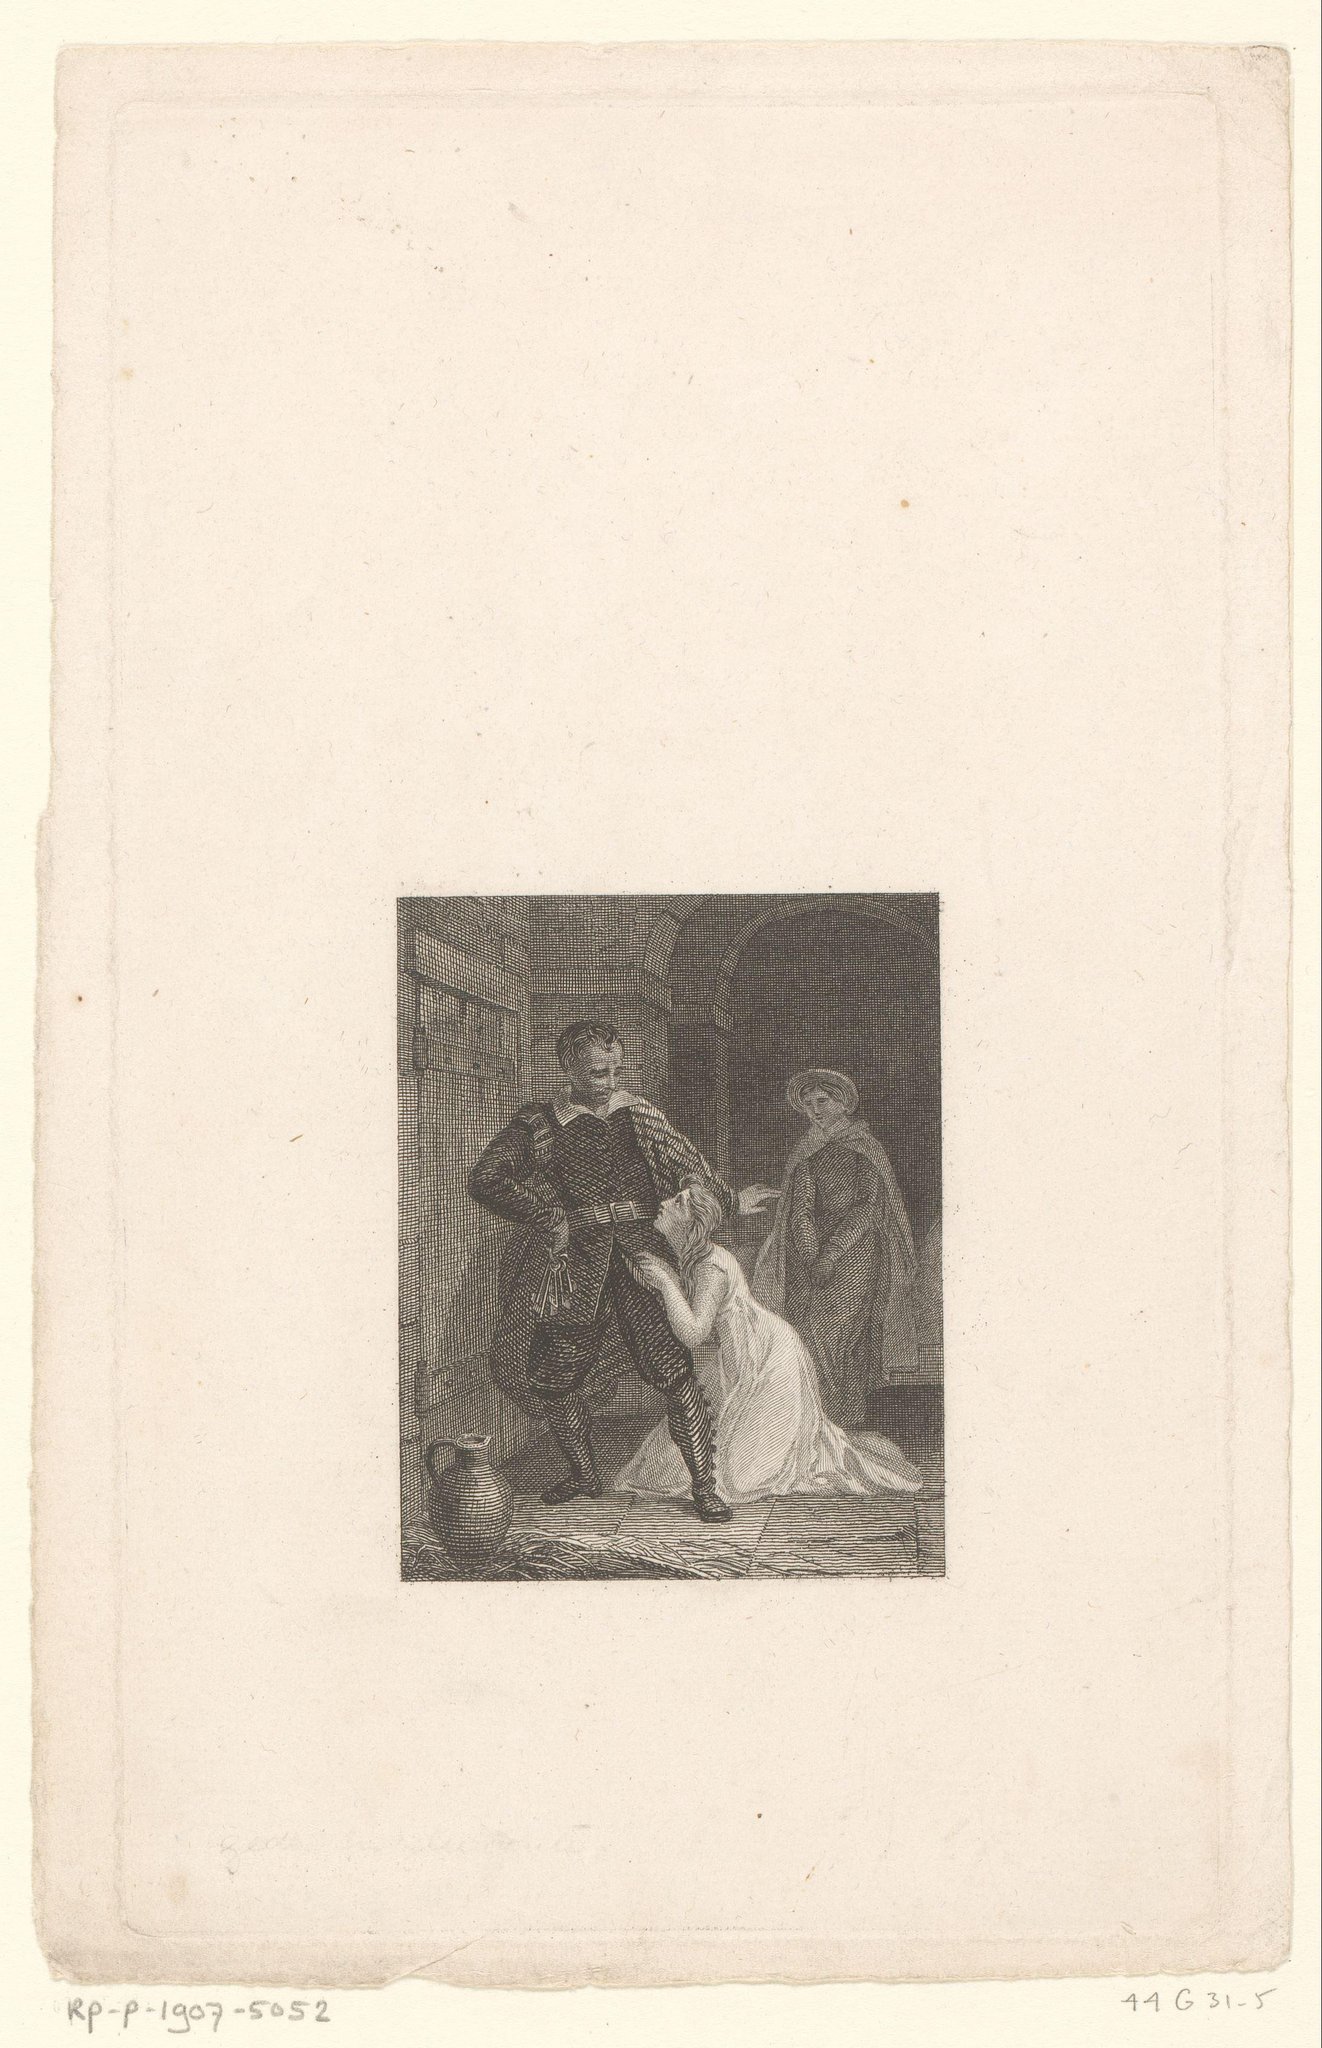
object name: print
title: Vrouwelijke gevangene klampt zich vast aan cipier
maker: Anonymous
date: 1800-1900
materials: paper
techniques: etching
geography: netherlands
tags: gripping someone by the legs, imprisonment, prison personnel: jailers, warders, guards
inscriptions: collector's mark: Lugt 2228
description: Prent is vermoedelijk een proefdruk voor een boekillustratie.